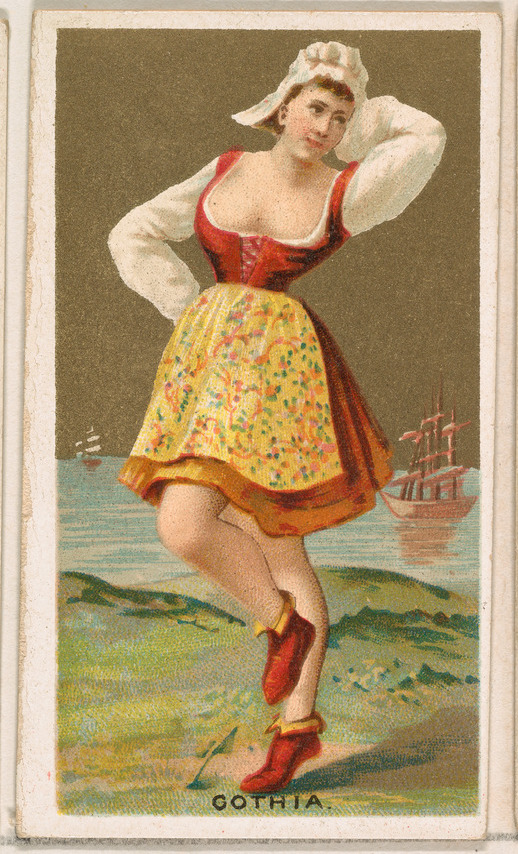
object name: print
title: Gothia, from the Dancing Girls of the World series (N185) issued by Wm. S. Kimball & Co.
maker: william s. kimball & company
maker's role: publisher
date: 1889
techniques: color lithograph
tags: women,dancing,dancers